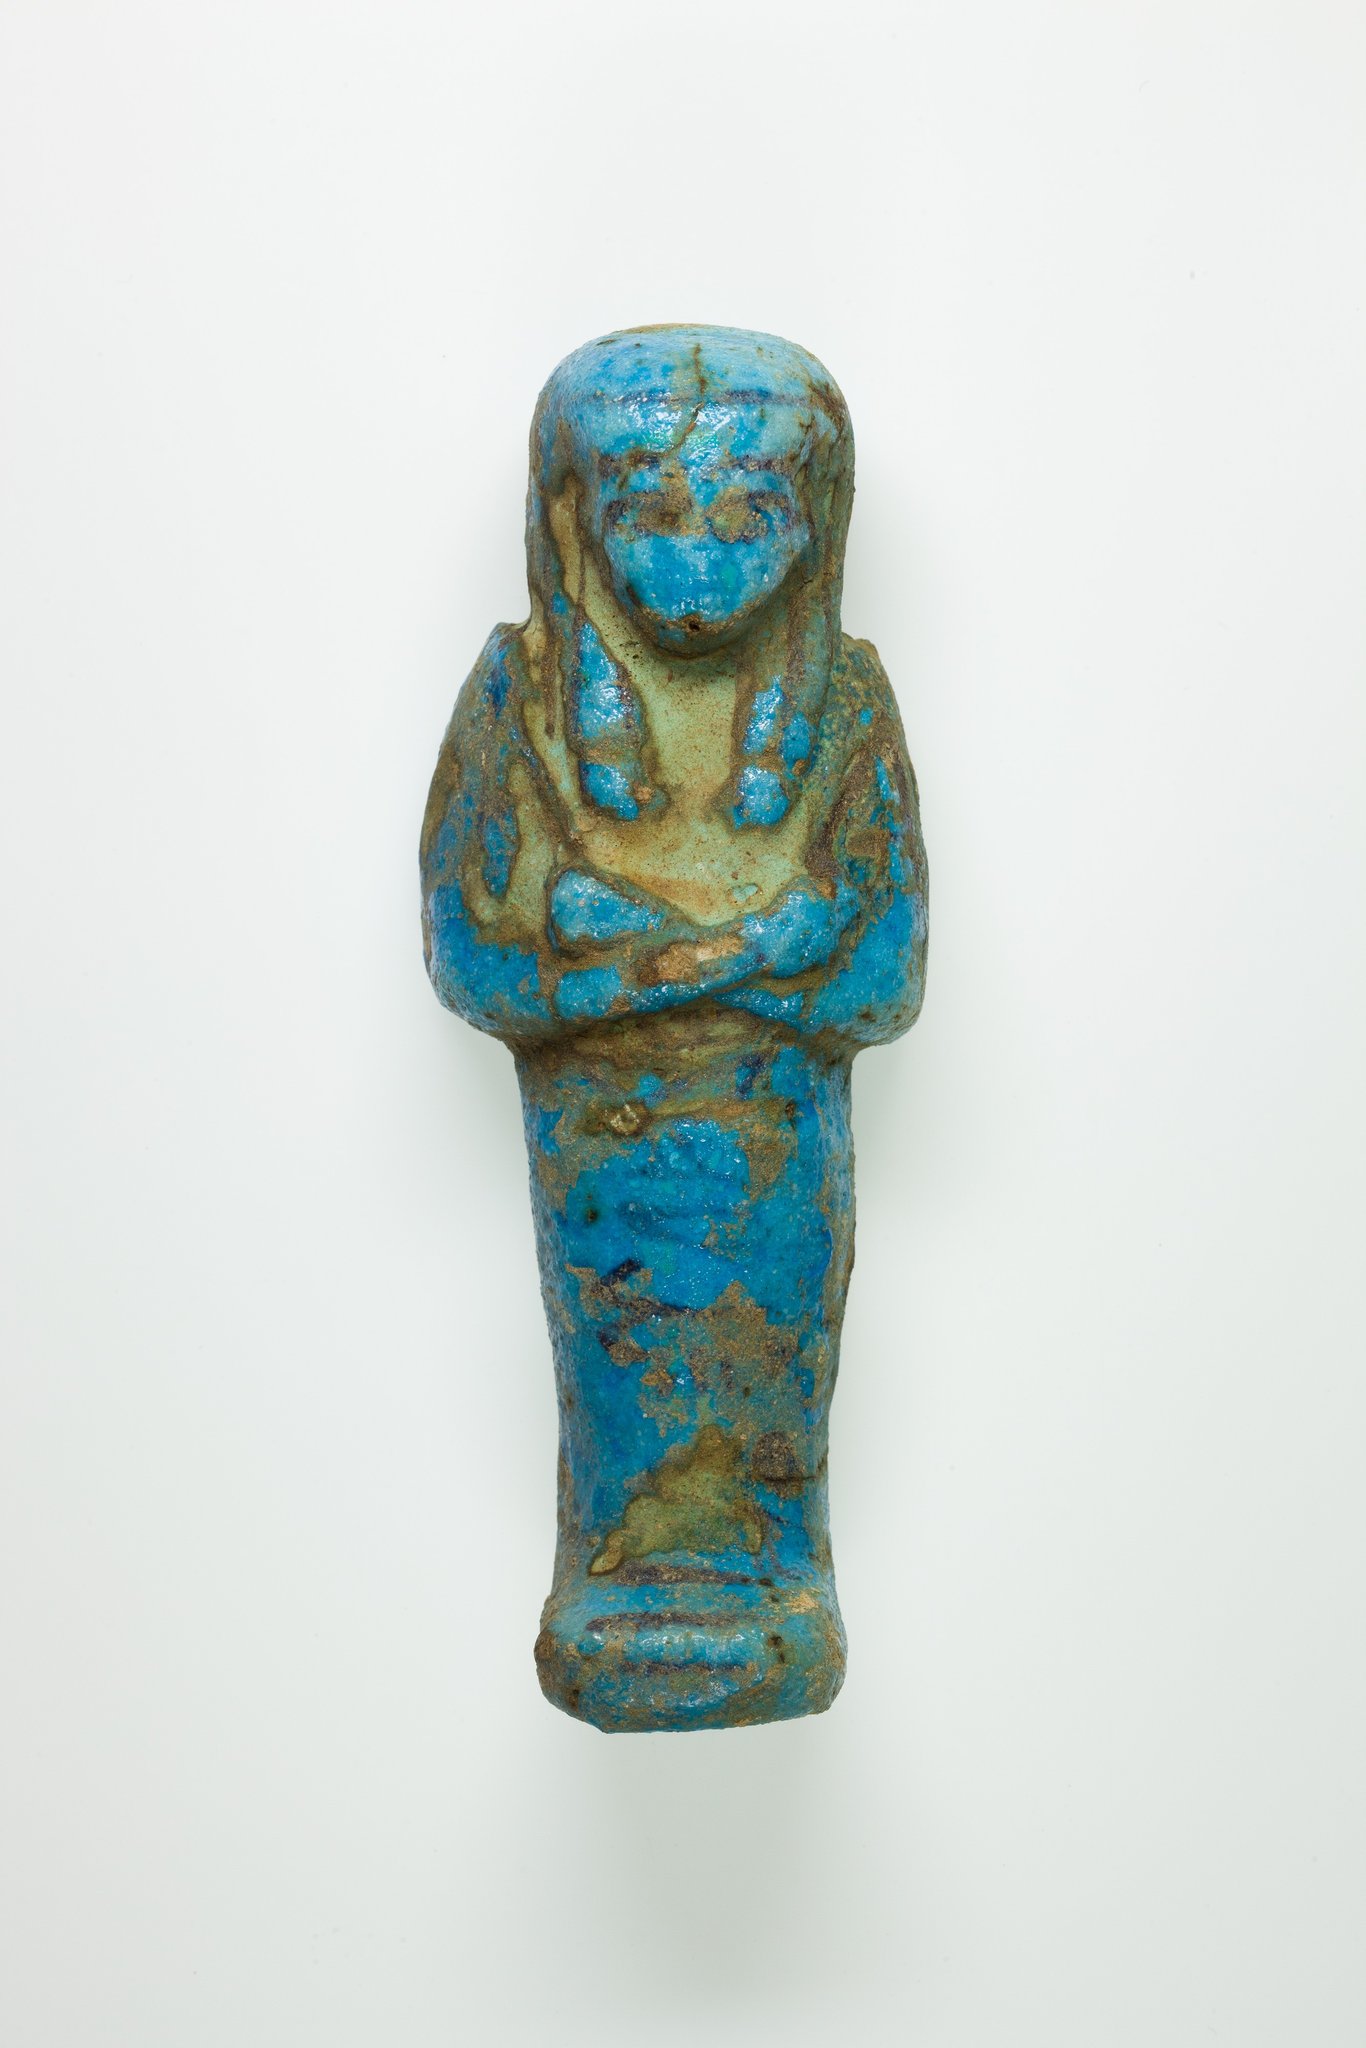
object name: worker shabti, henettawy c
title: Worker Shabti of Henettawy (C), Daughter of Isetemkheb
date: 990-970 BCE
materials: faience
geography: egypt